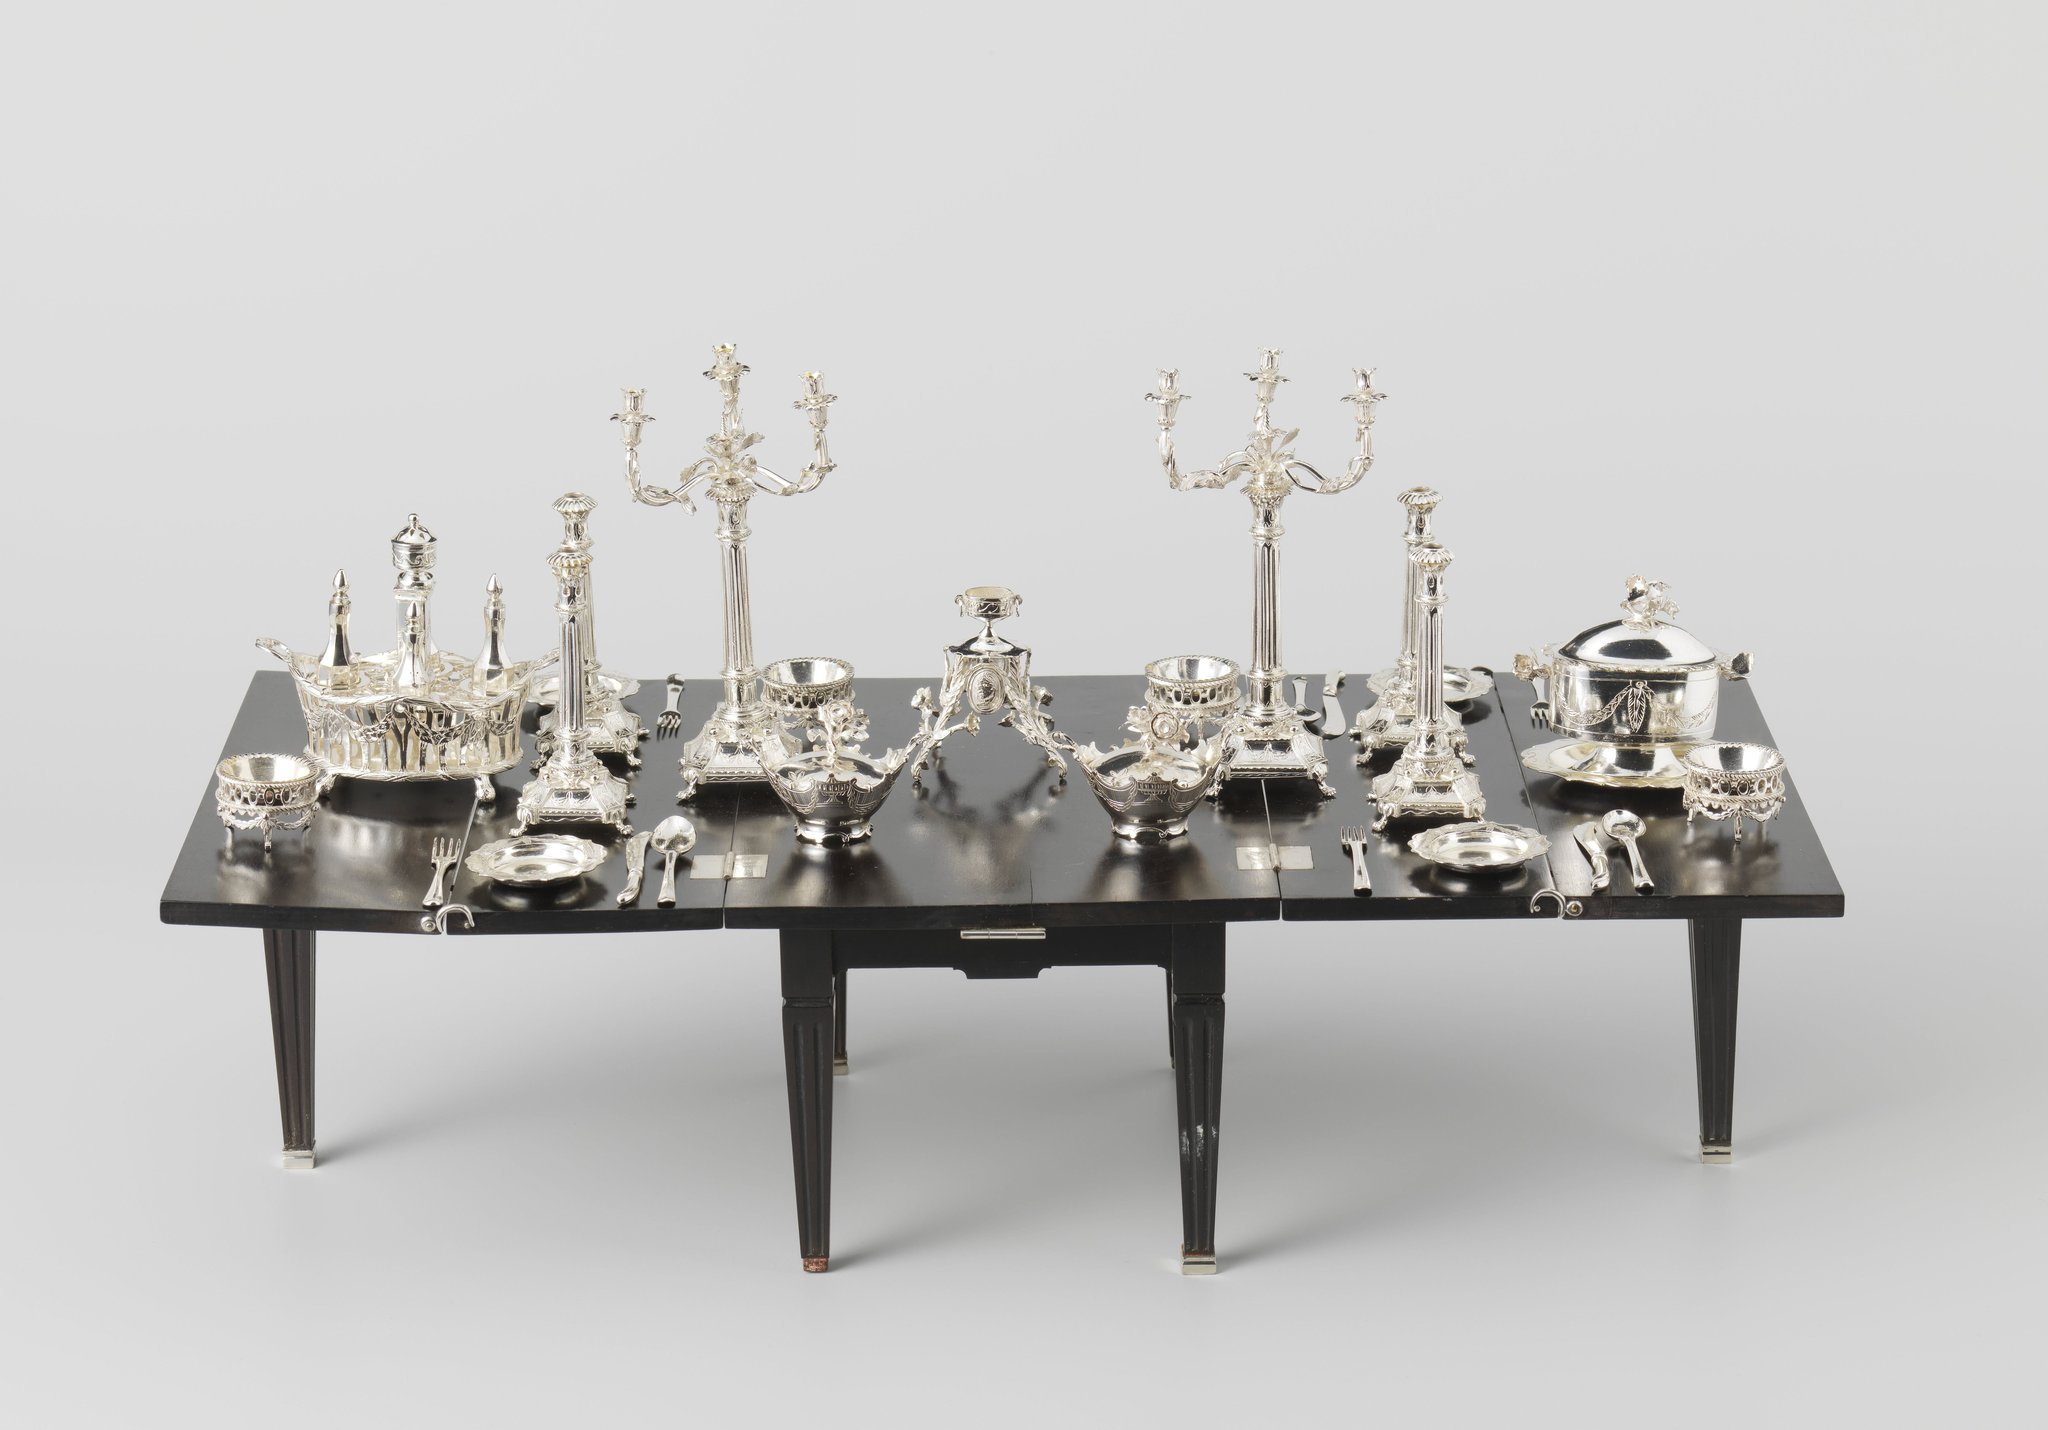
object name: miniature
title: Bord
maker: Anonymous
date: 1782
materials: silver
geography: amsterdam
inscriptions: maker's mark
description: Rond eetbord met geschulpte rand. Op de rand zijn guirlandes gegraveerd.In het midden van het bord is een bloem gegraveerd. Het bord is gemerkt: stk.= Amsterdam, jrl.= X (1782) en mt.= Voet 430. Het bord is een exemplaar van een set bestaande uit 36 identieke borden (BK-NM-11177-189 t/m BK-NM-11177-224).